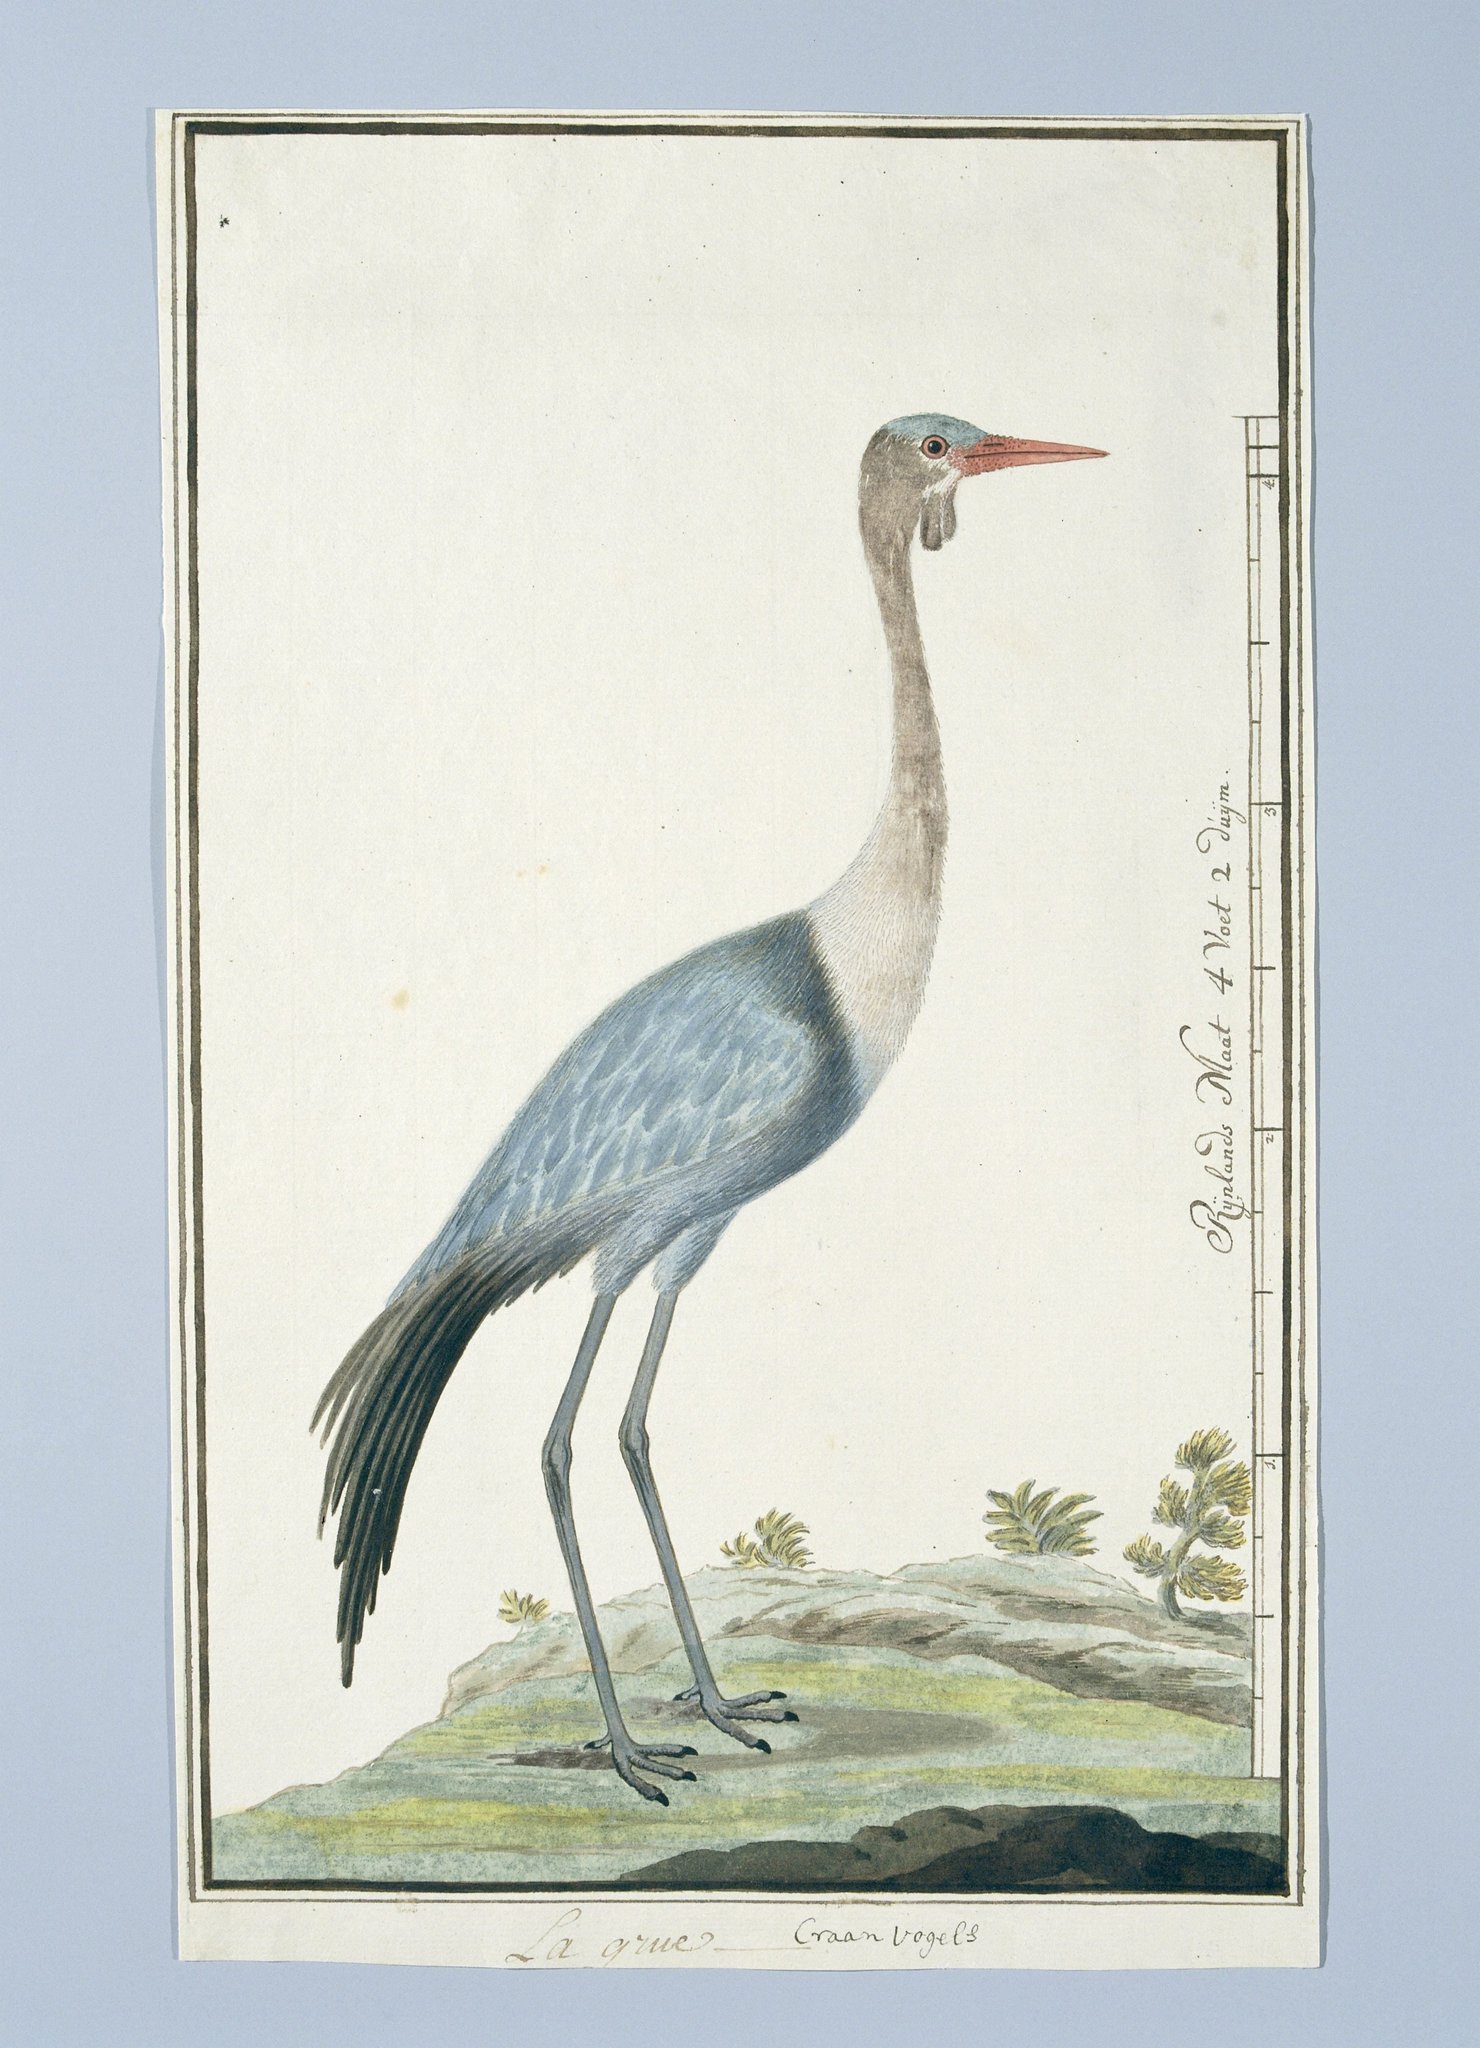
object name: album leaf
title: Grus carunculatus/ Bugeranus carunculatus (Wattled crane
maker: robert jacob gordon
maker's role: draughtsman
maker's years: 1743-1795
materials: chalk, ink, paper, pencil, watercolor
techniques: brush, pen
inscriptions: annotation: ‘La Grue; Craan Vogels; schaalverdeling met: Rijnlands Maat 4 Voet 2 duijm’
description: Vogelstudie: Lelparadijsvogel (Bugeranus carunculatus), met schaalverdeling in Rijnlandse maat.